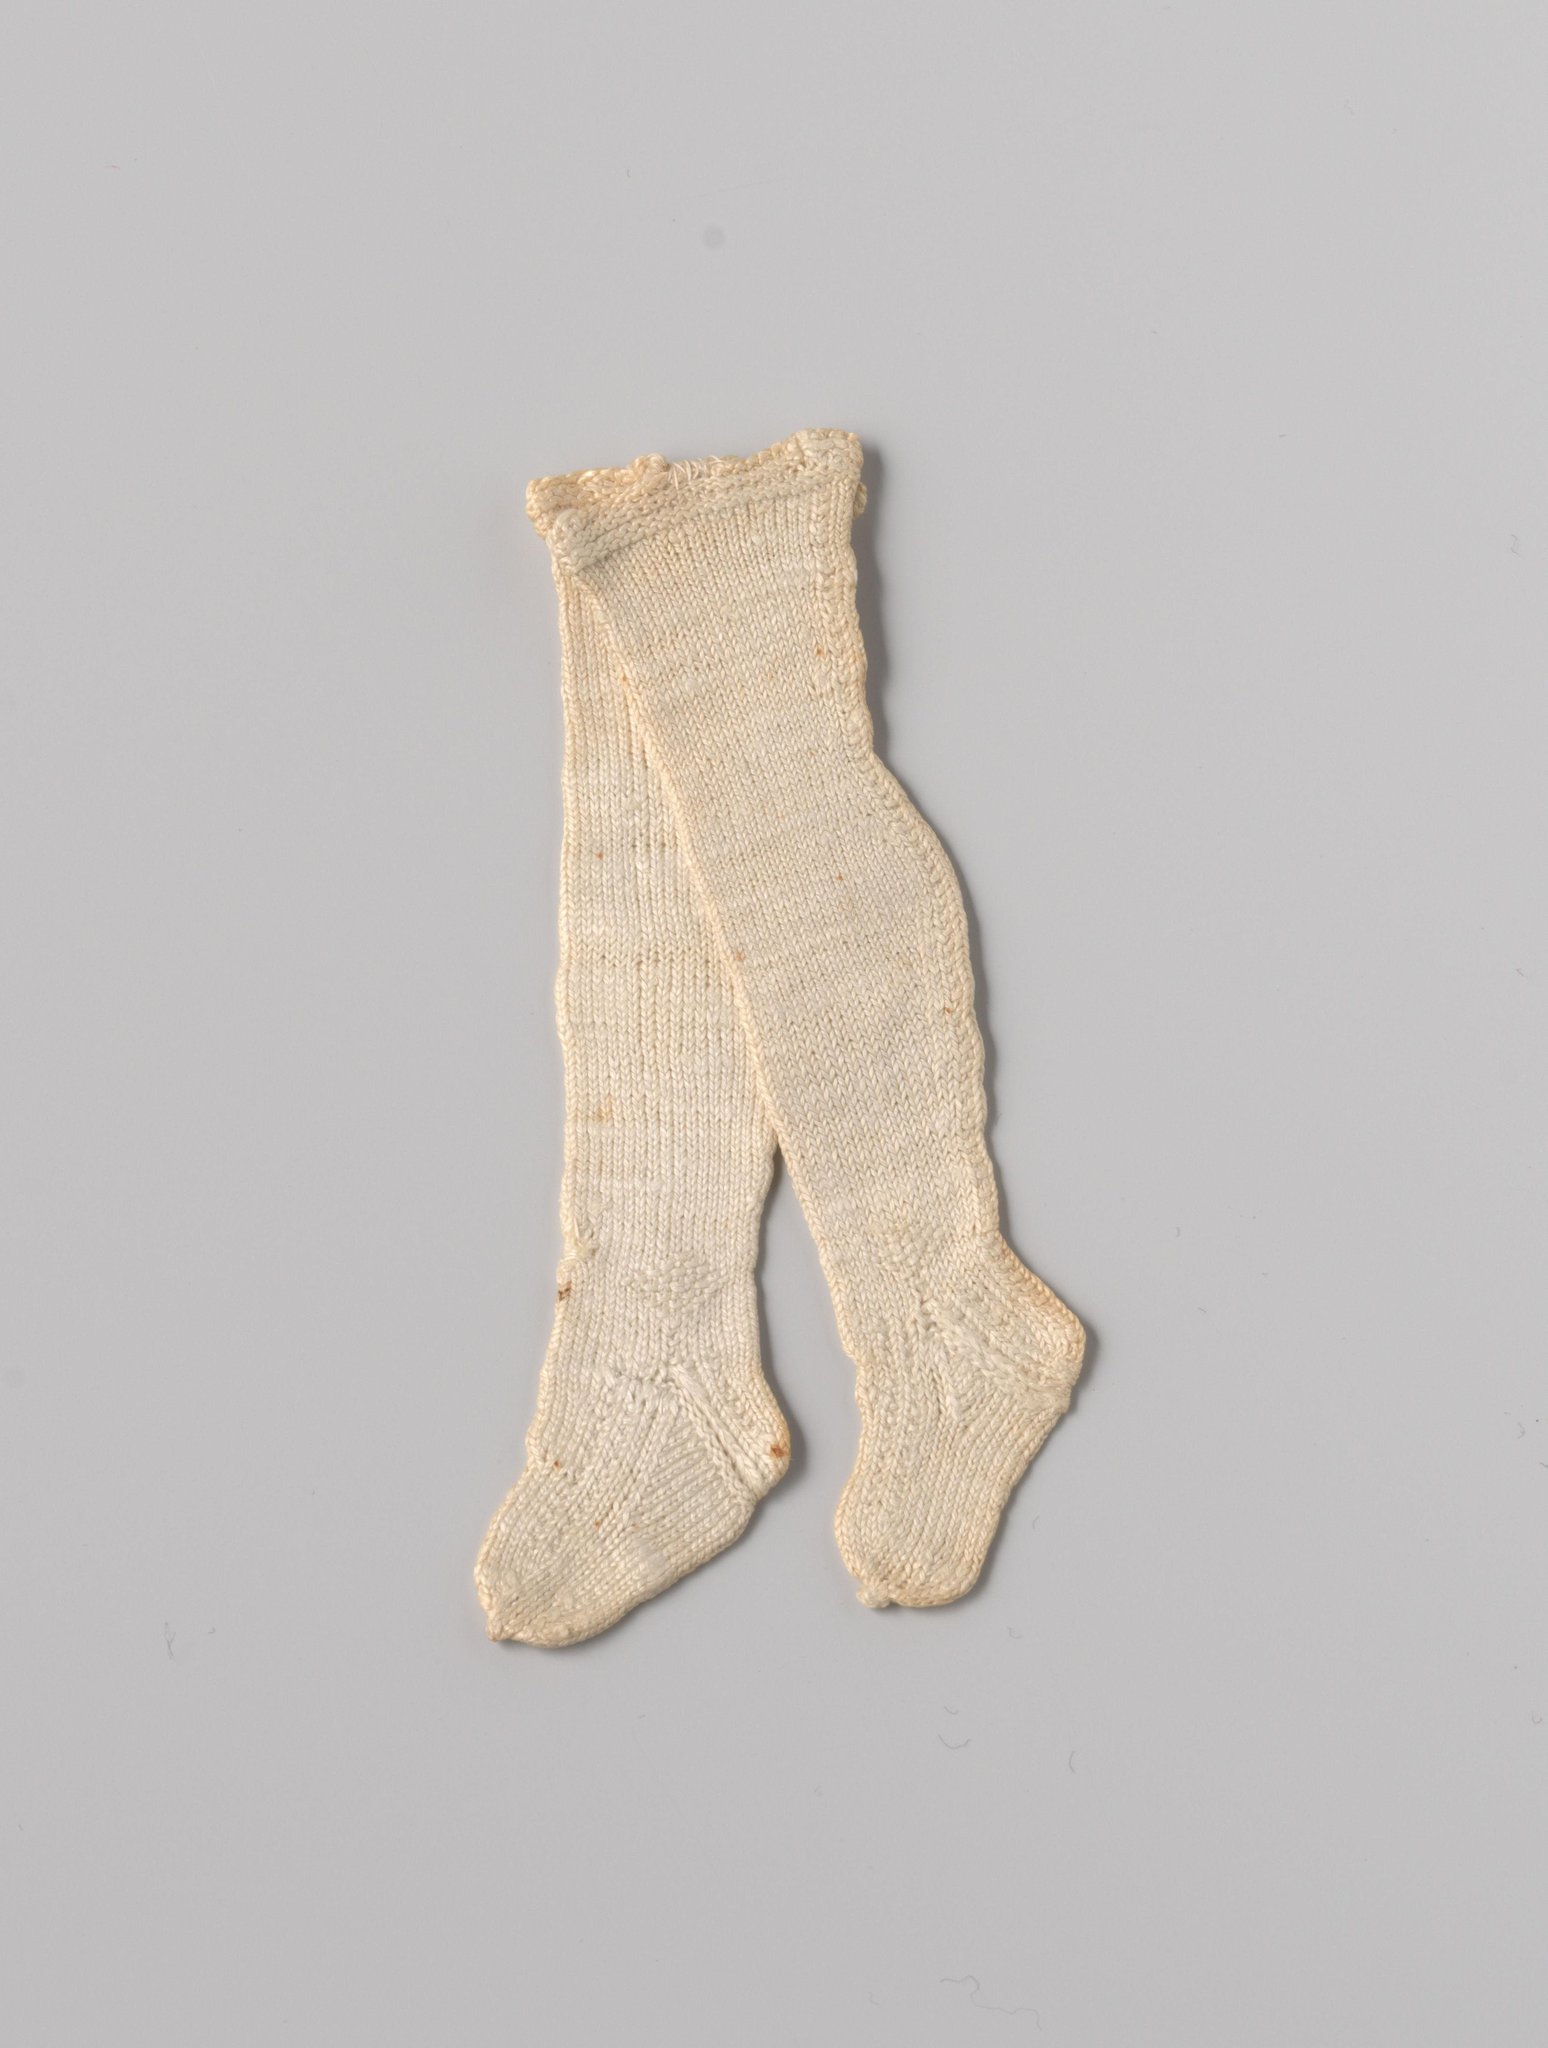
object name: stocking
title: Kous met een ruitmotief in gerstekorrelsteek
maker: Anonymous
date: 1690-1710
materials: linen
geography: amsterdam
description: De kous is gebreid van wit linnen, met een teenstuk, een kleine en een grote hiel, een kuit, middenachter een naad en ter hoogte van de enkel een ruitmotief in gestekorrelsteek.